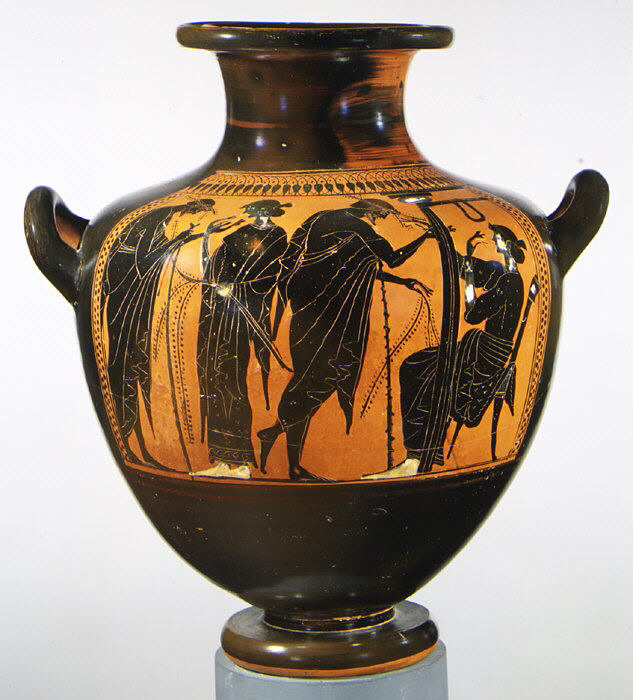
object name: hydria, kalpis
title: Terracotta hydria: kalpis (water jar)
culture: greek, attic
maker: eucharides painter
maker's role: artist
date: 510 BCE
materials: terracotta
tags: men,women